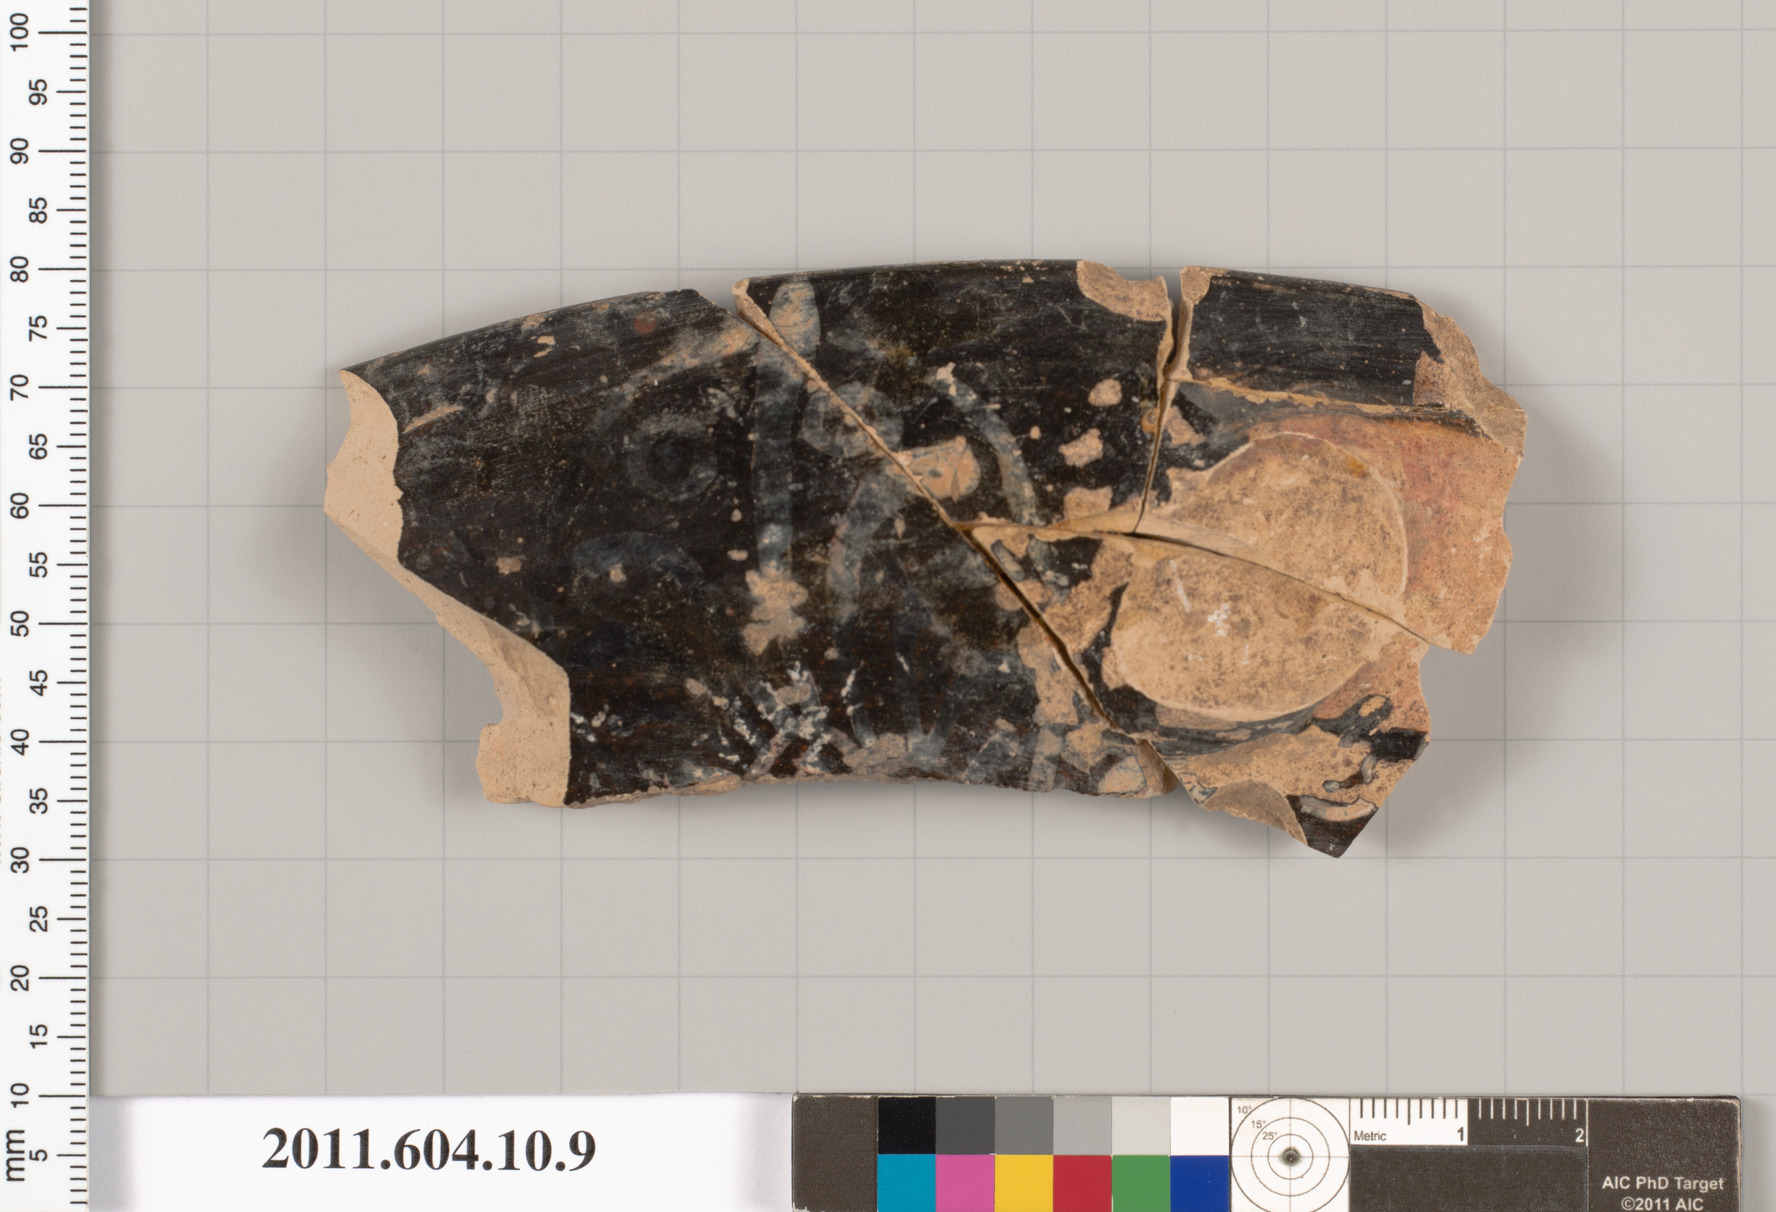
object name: kylix fragment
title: Terracotta fragment of a kylix (drinking cup)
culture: etruscan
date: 434-368 BCE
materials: terracotta